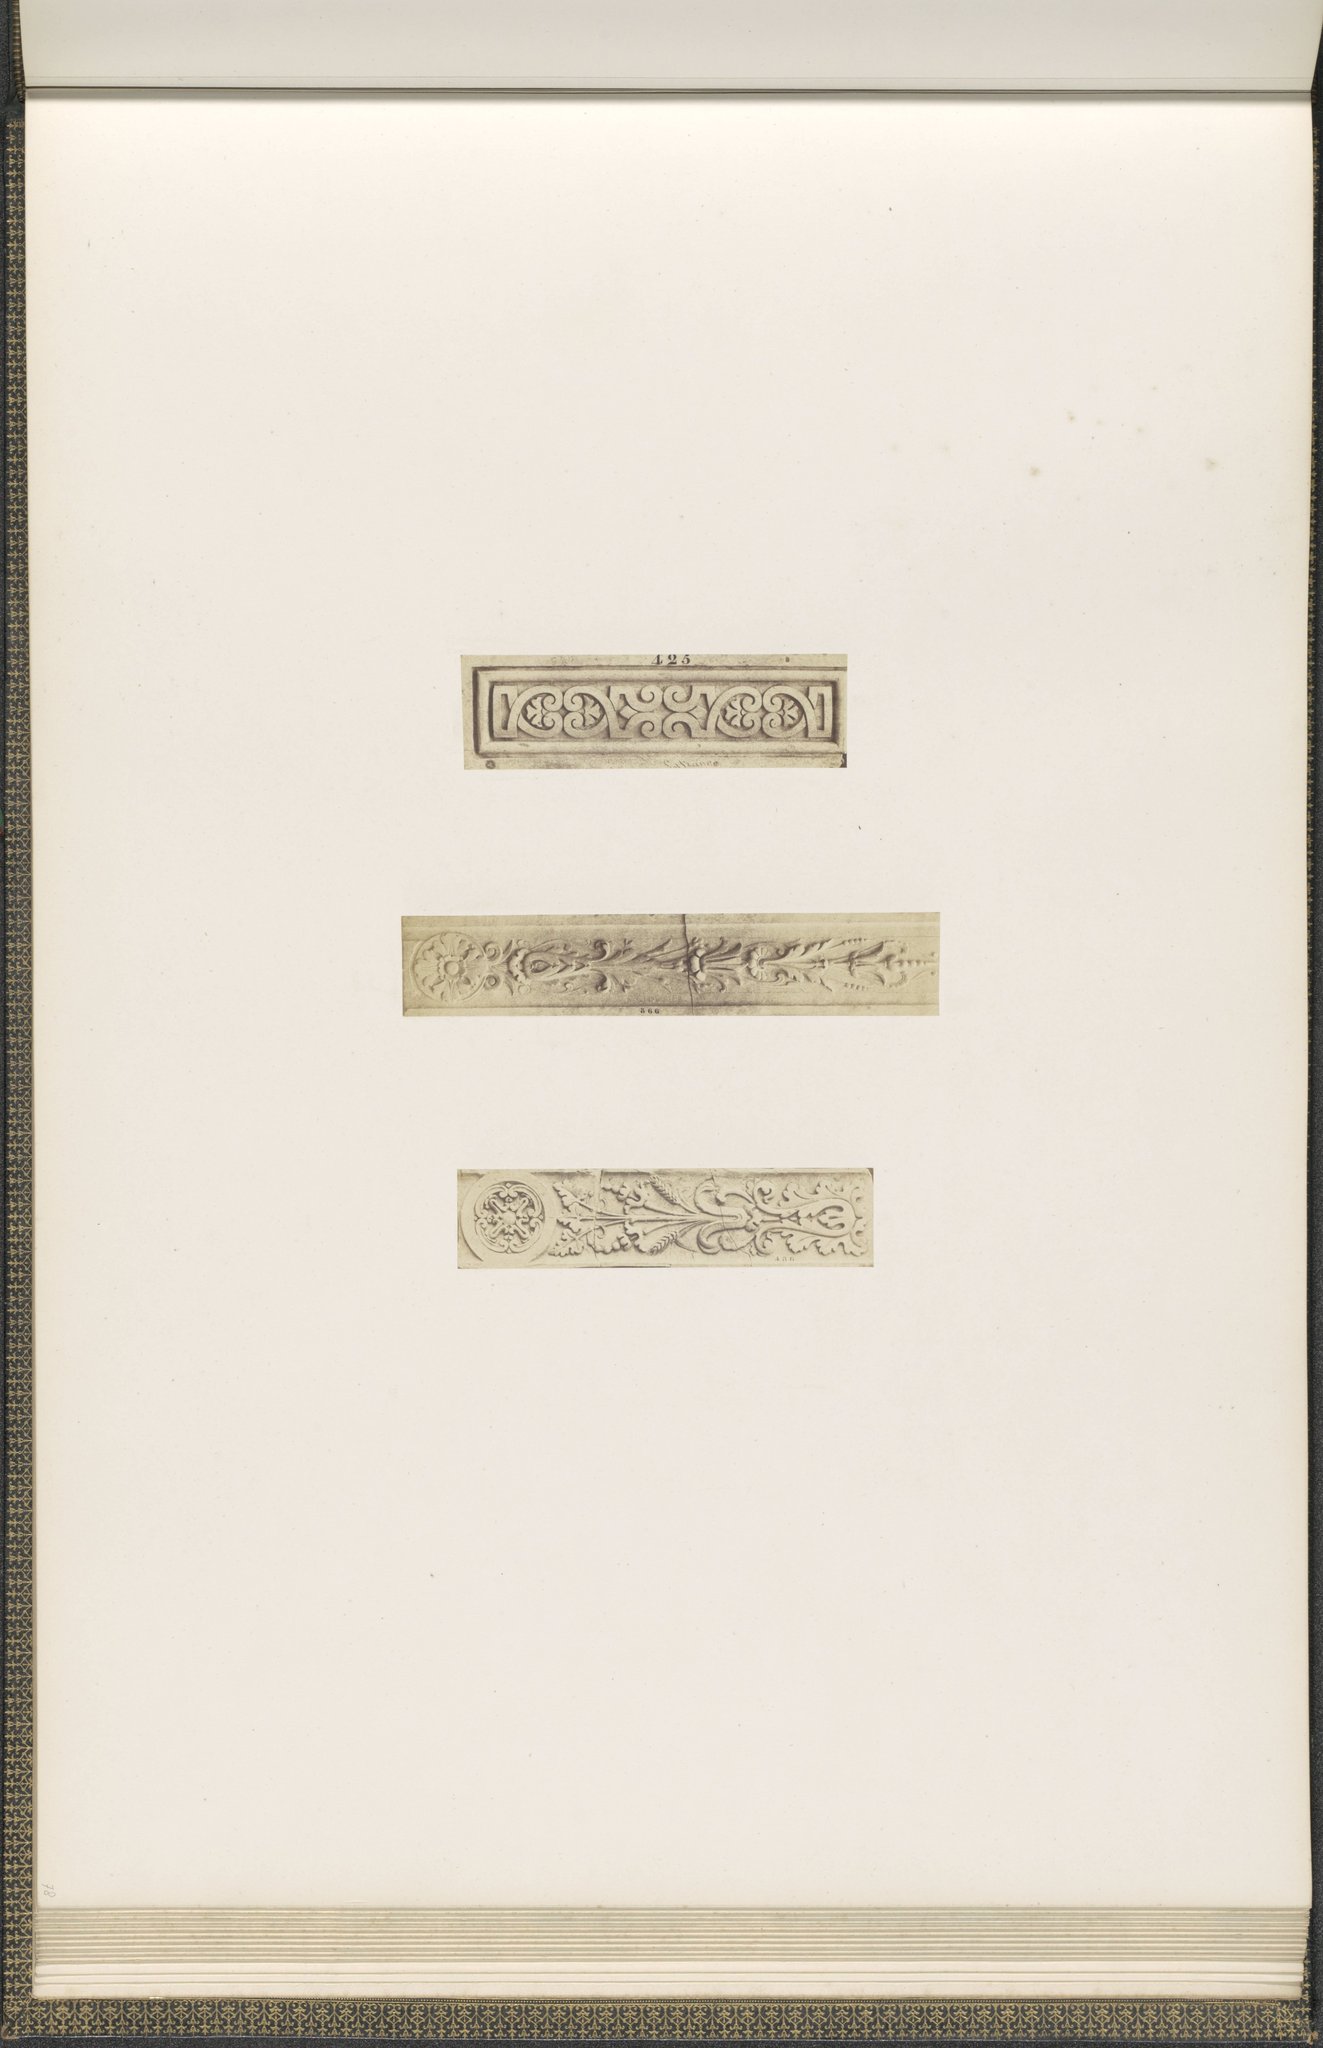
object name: album leaf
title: Gipsmodellen voor versieringen van het Palais du Louvre: links door Jules Lafrance, midden door Pierre Edouard Charrier, rechts onbekend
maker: édouard denis baldus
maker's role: fotograaf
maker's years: 1813-1889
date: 1855-1857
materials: paper, photographic support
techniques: salted paper print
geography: paris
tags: permanent exhibition, museum, ornamenting, decorating ~ applied arts, paris, tuileries palace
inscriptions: number: ‘435, 866, 486 (vlnr)’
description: Onderdeel van Réunion des Tuileries au Louvre 1852-1857, album 4.